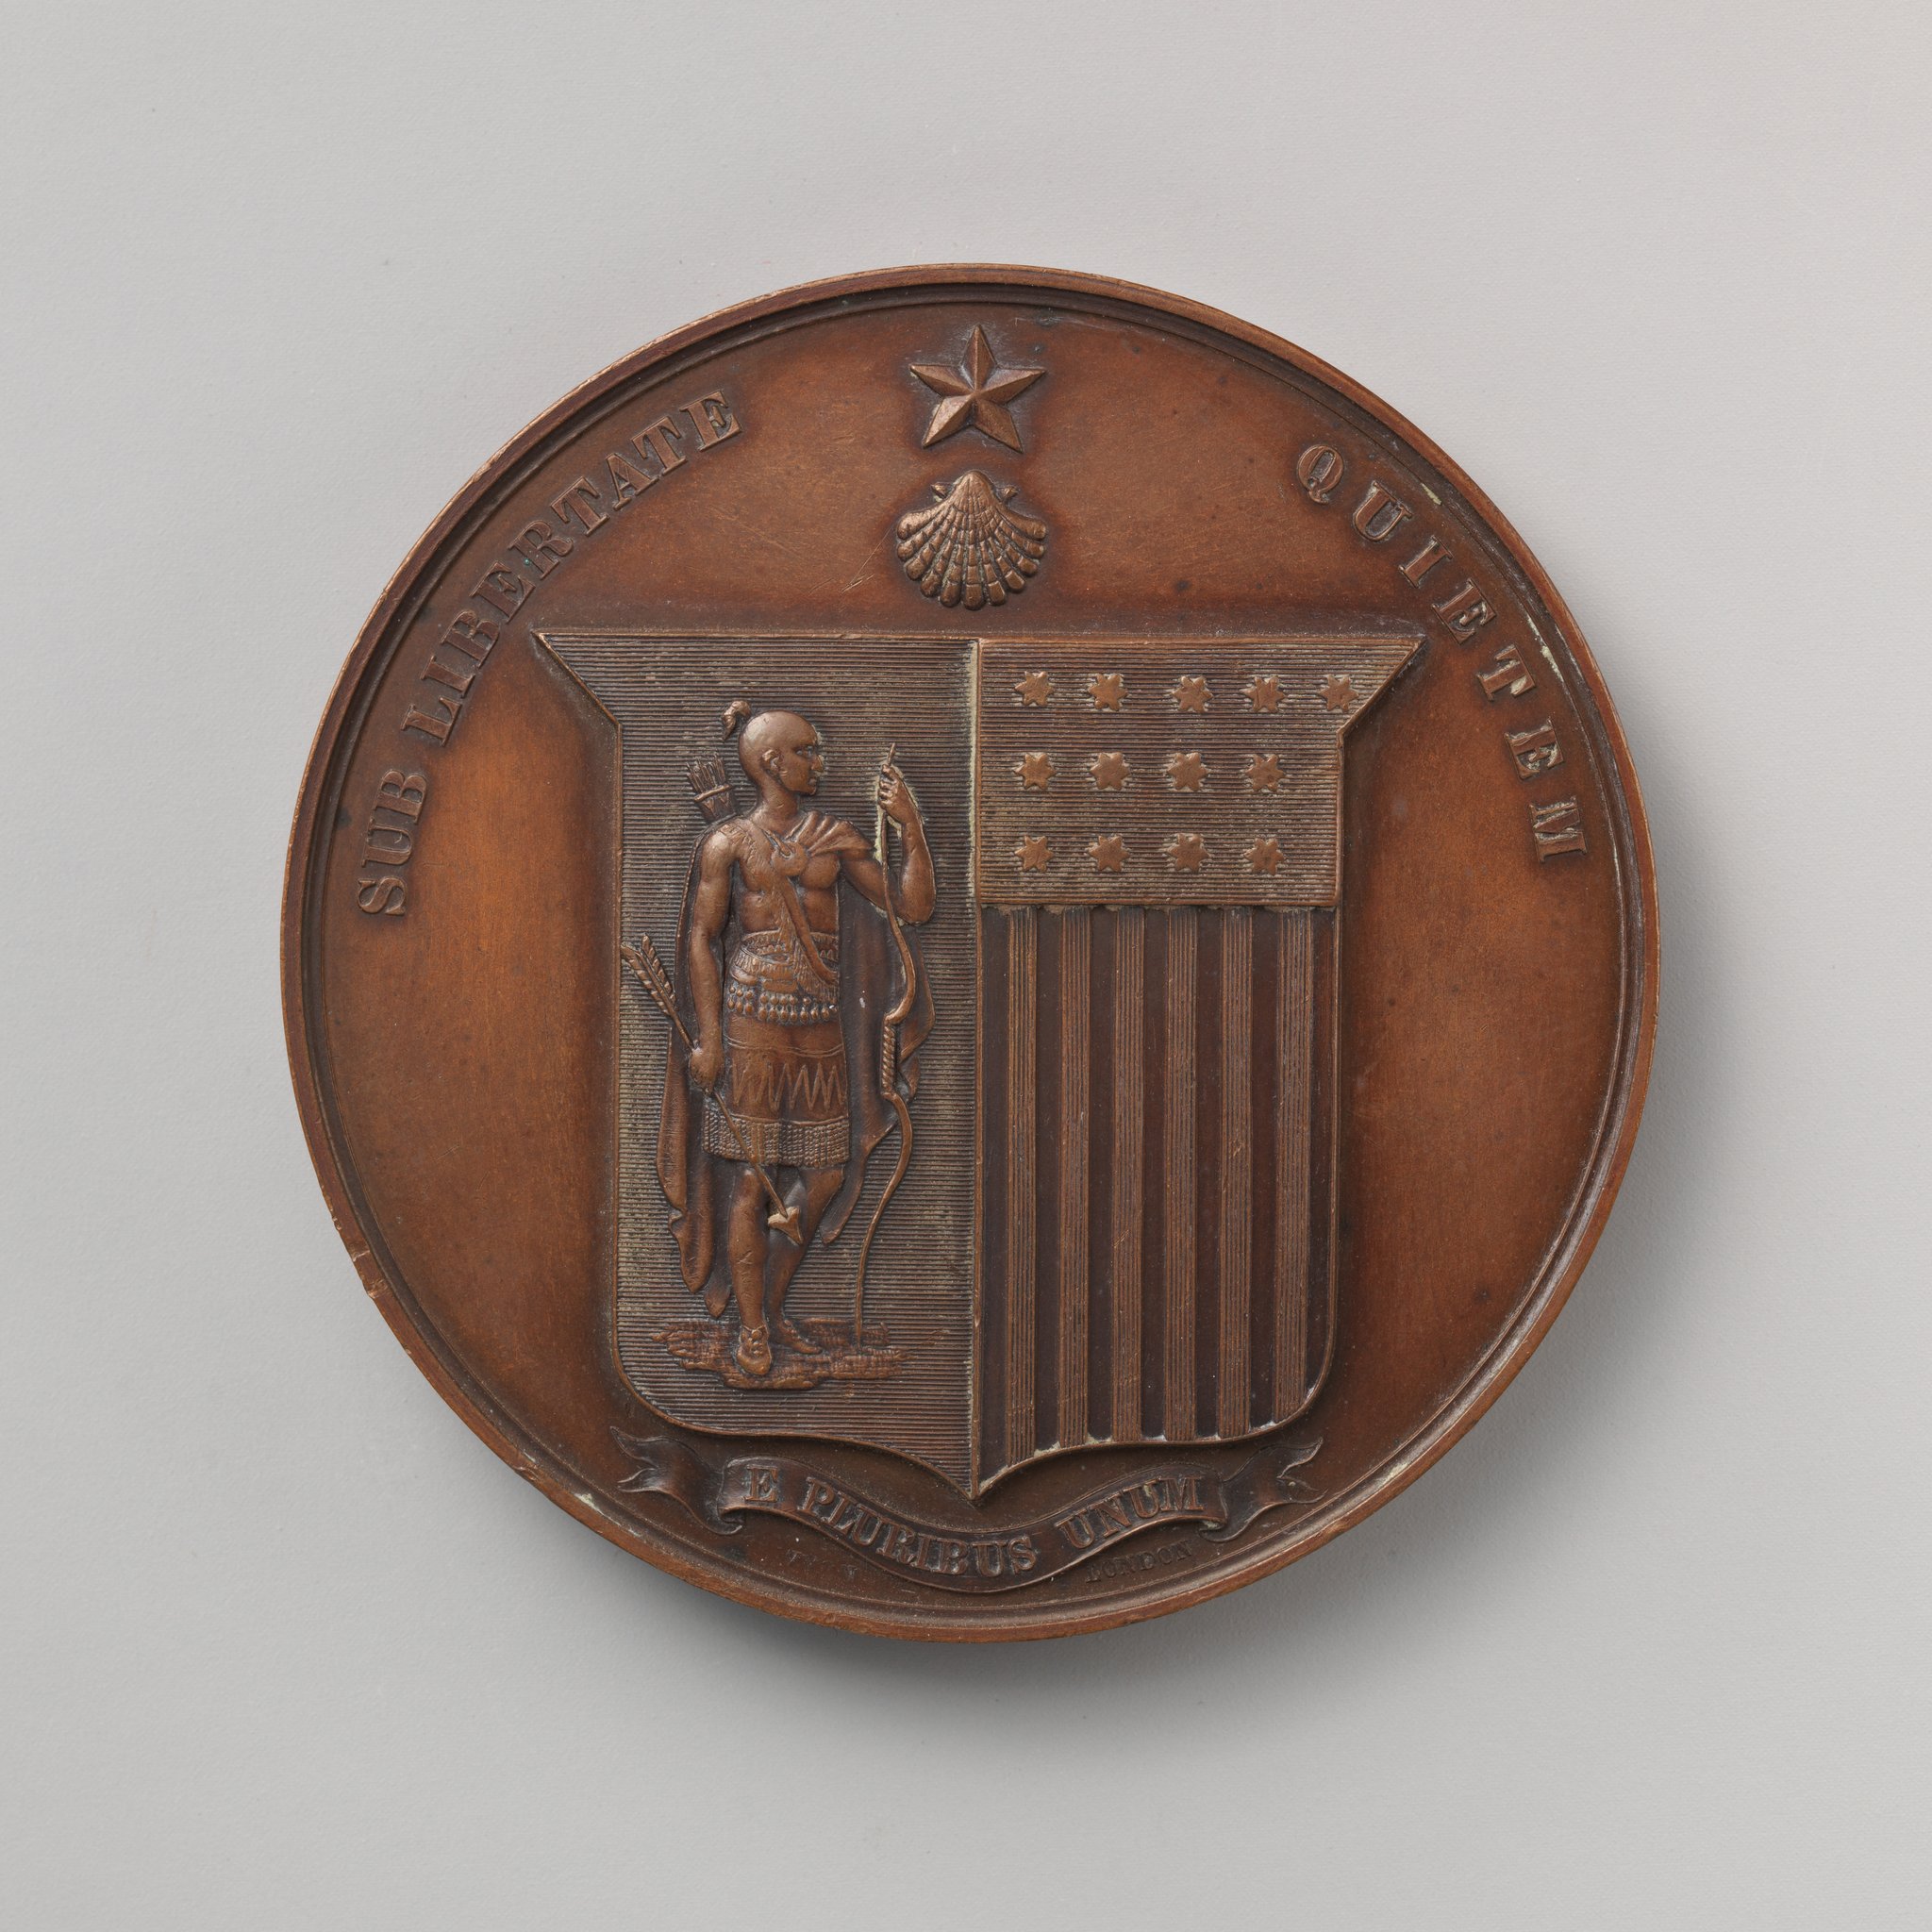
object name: medal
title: Award of the Massachusetts Humane Society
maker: benjamin wyon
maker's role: artist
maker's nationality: british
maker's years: 1802-1858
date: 1801-1900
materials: bronze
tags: hands,men,stars,insignia